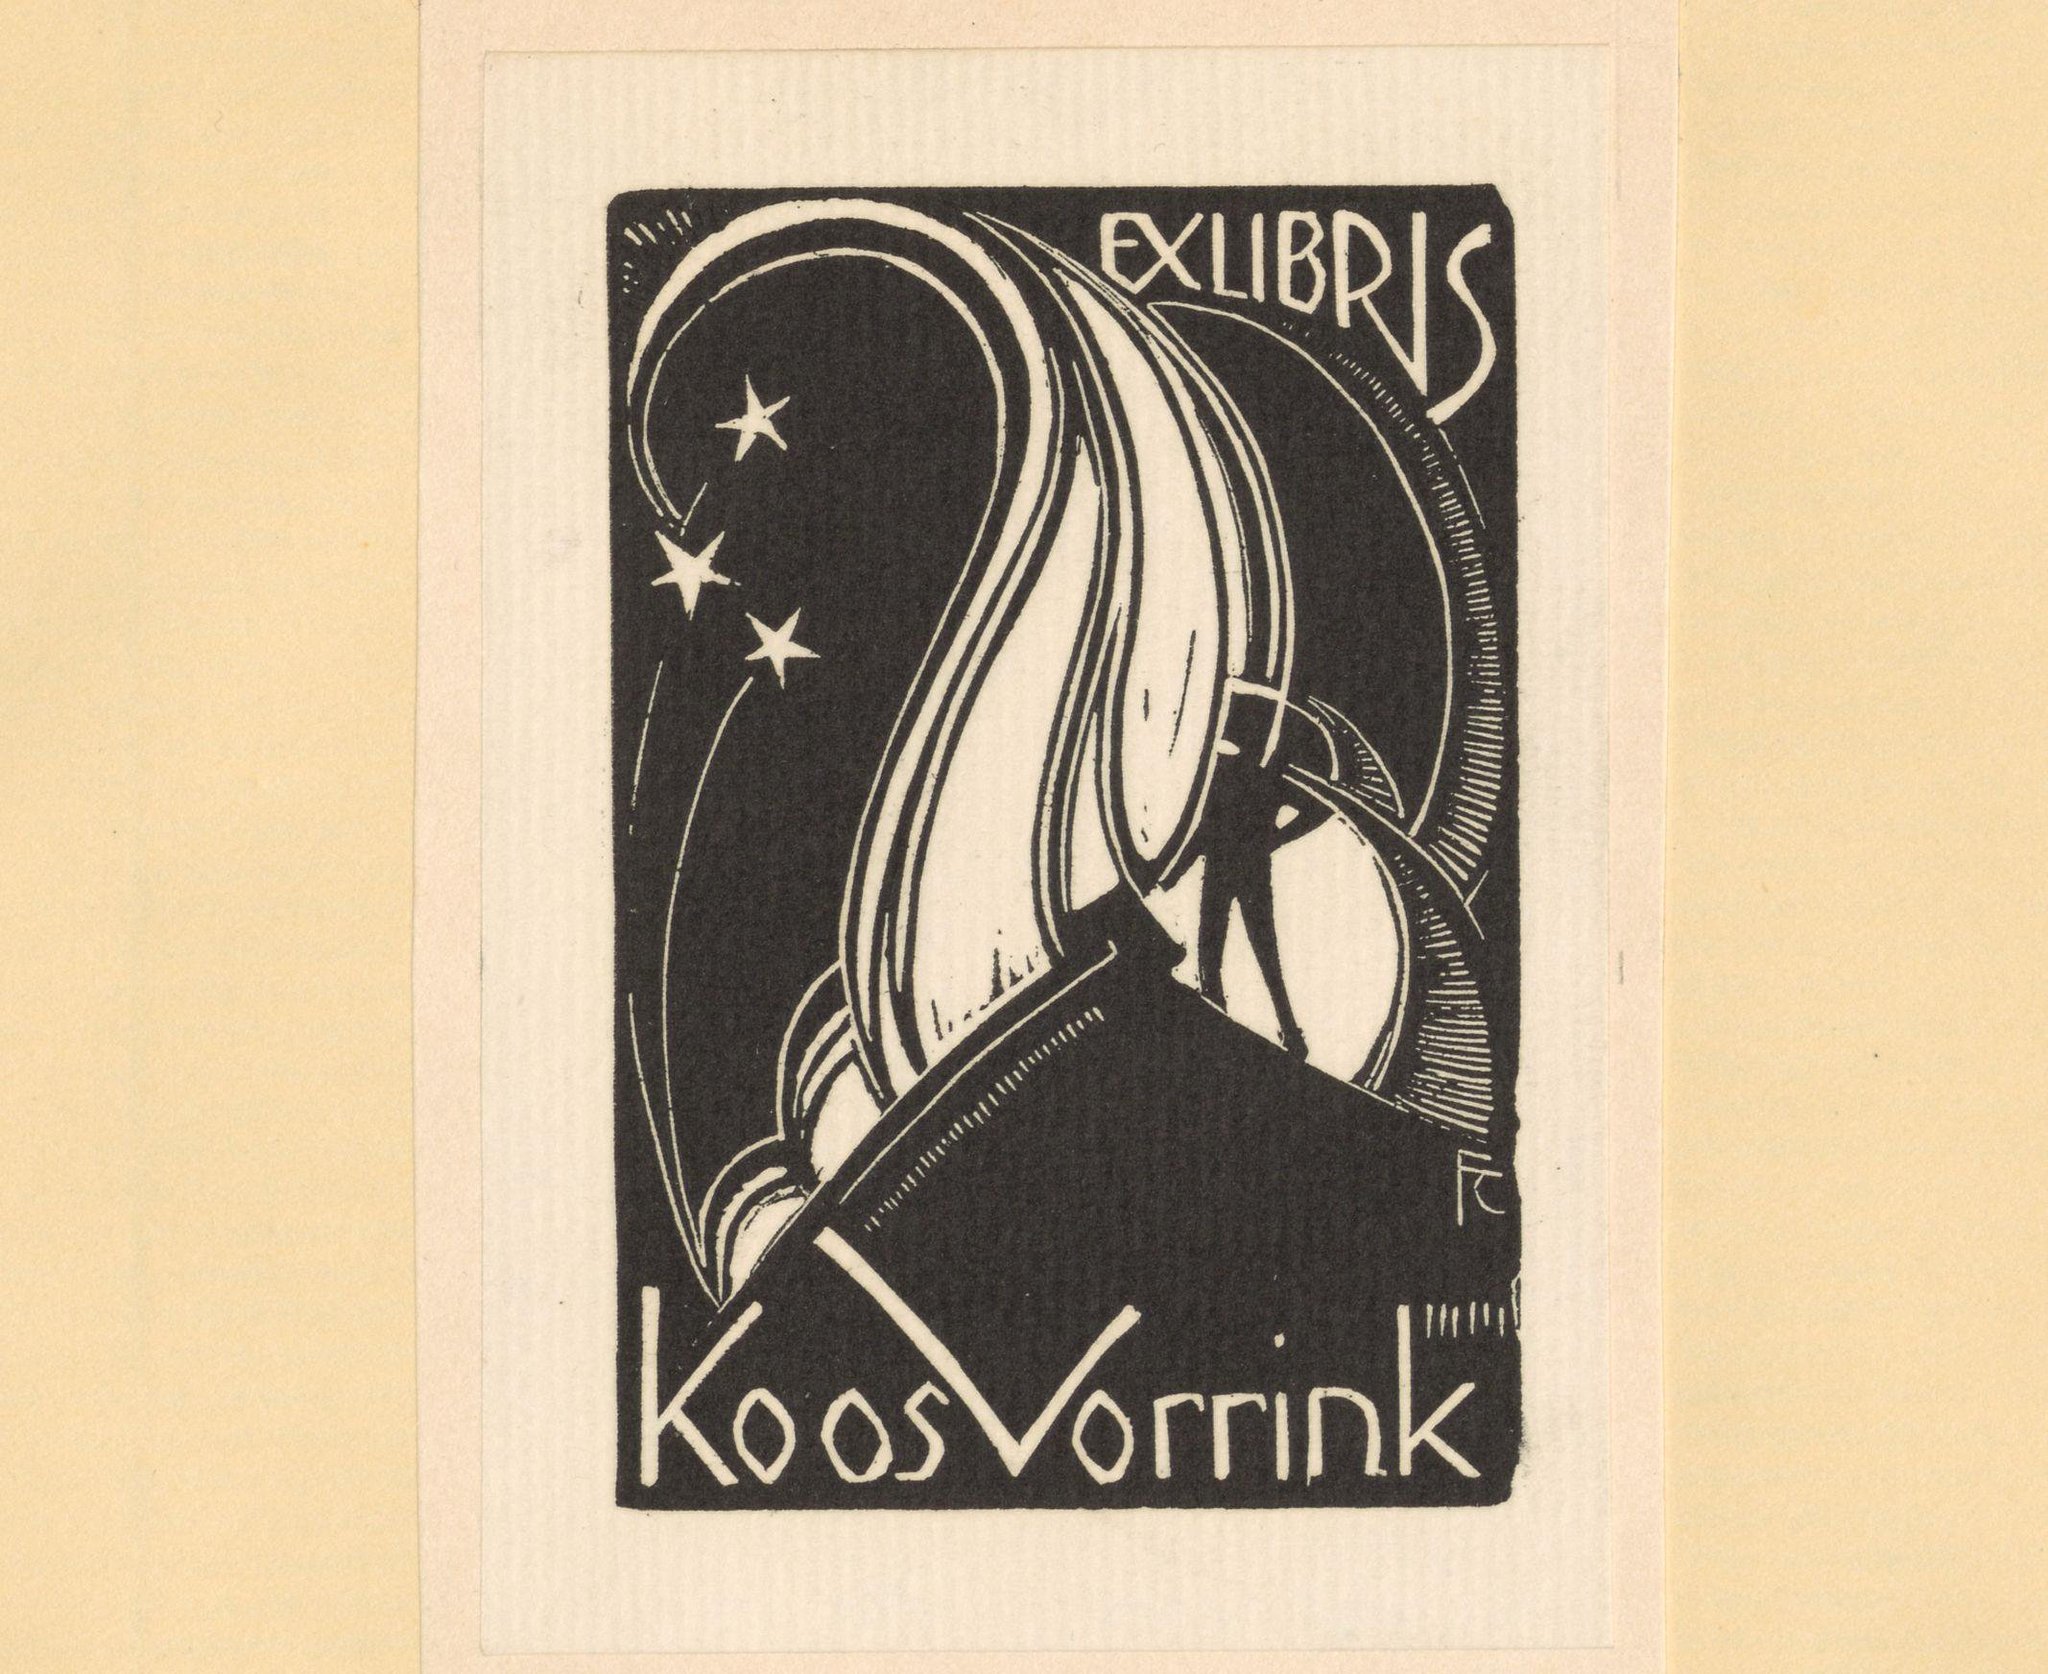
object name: bookplate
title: Ex libris van Koos Vorrink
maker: fré cohen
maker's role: draughtsman, print maker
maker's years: 1903-1943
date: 1926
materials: paper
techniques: woodcut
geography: netherlands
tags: amsterdam, politician, jacobus jan vorrink (koos), standing figure, stars